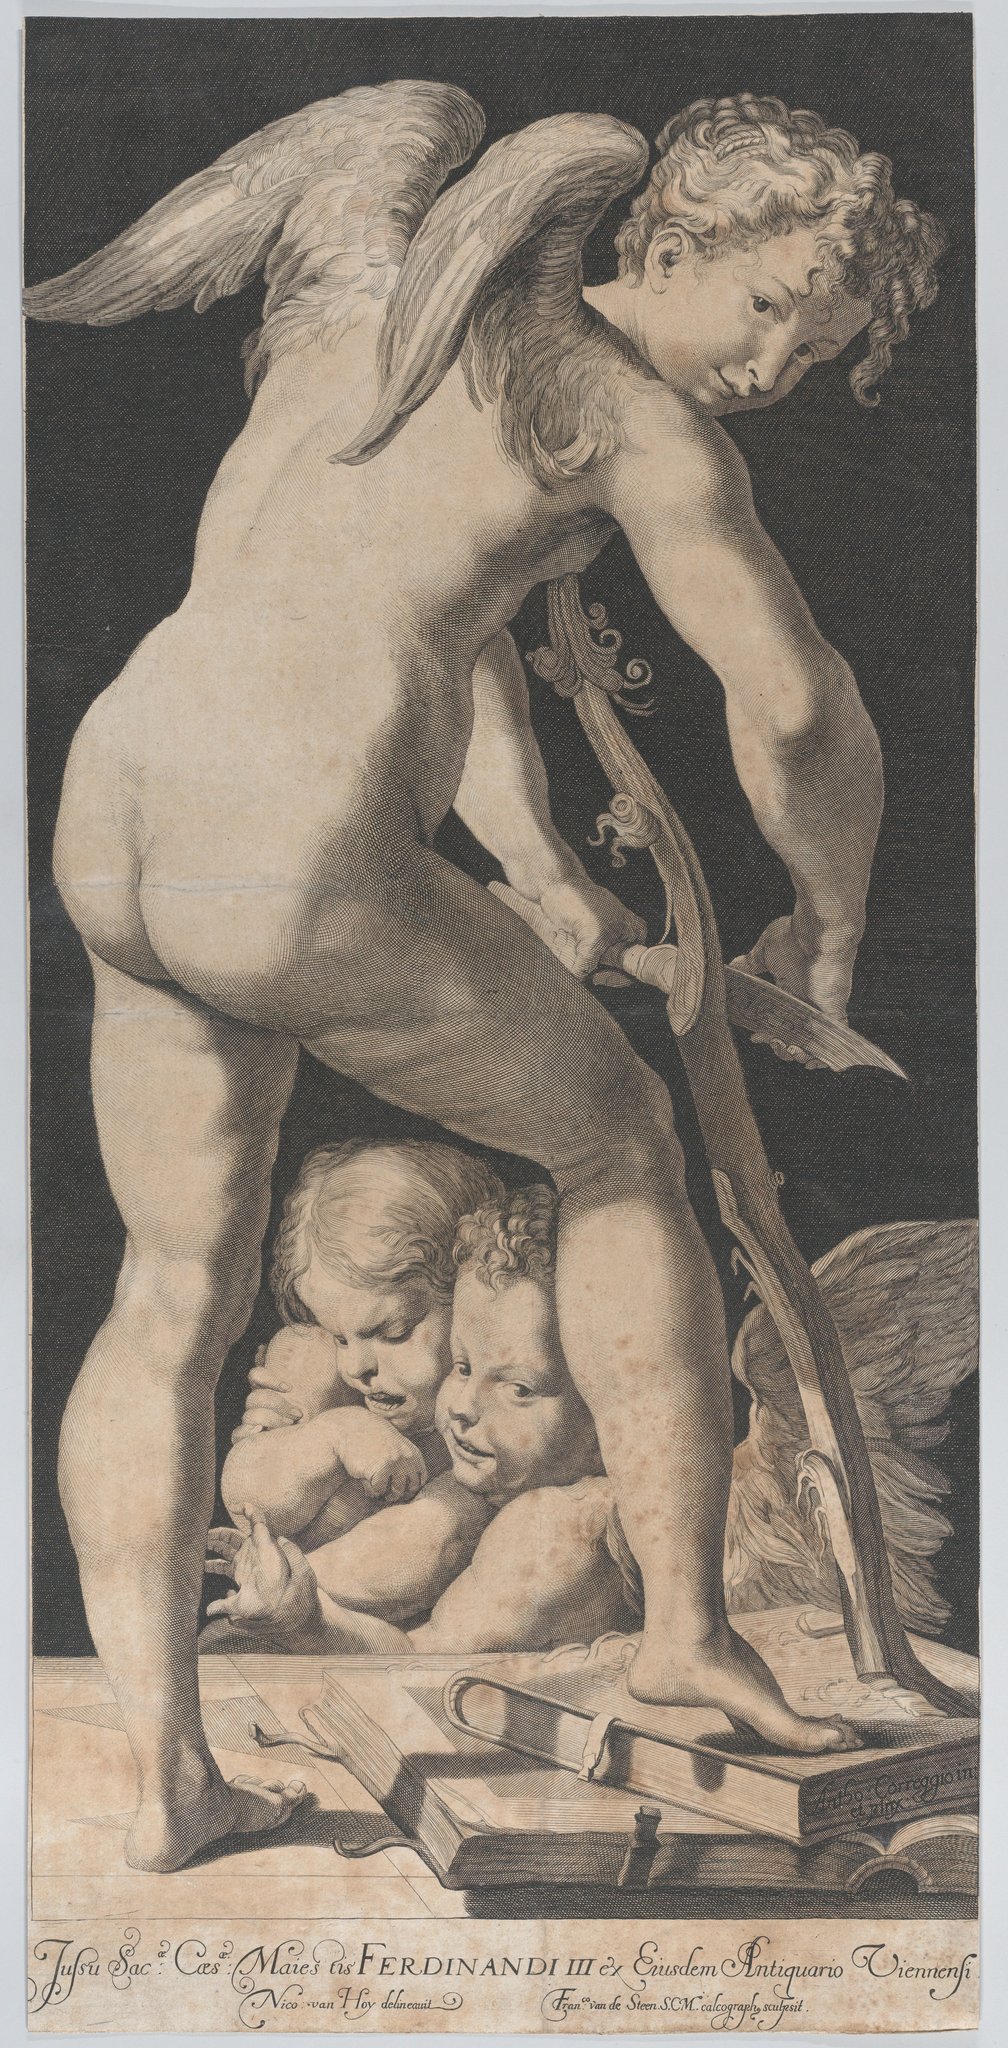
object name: print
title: Cupid sharpening his bow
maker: franciscus van den steen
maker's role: artist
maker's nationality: netherlandish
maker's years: 1625-1672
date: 1645-1672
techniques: engraving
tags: cupid